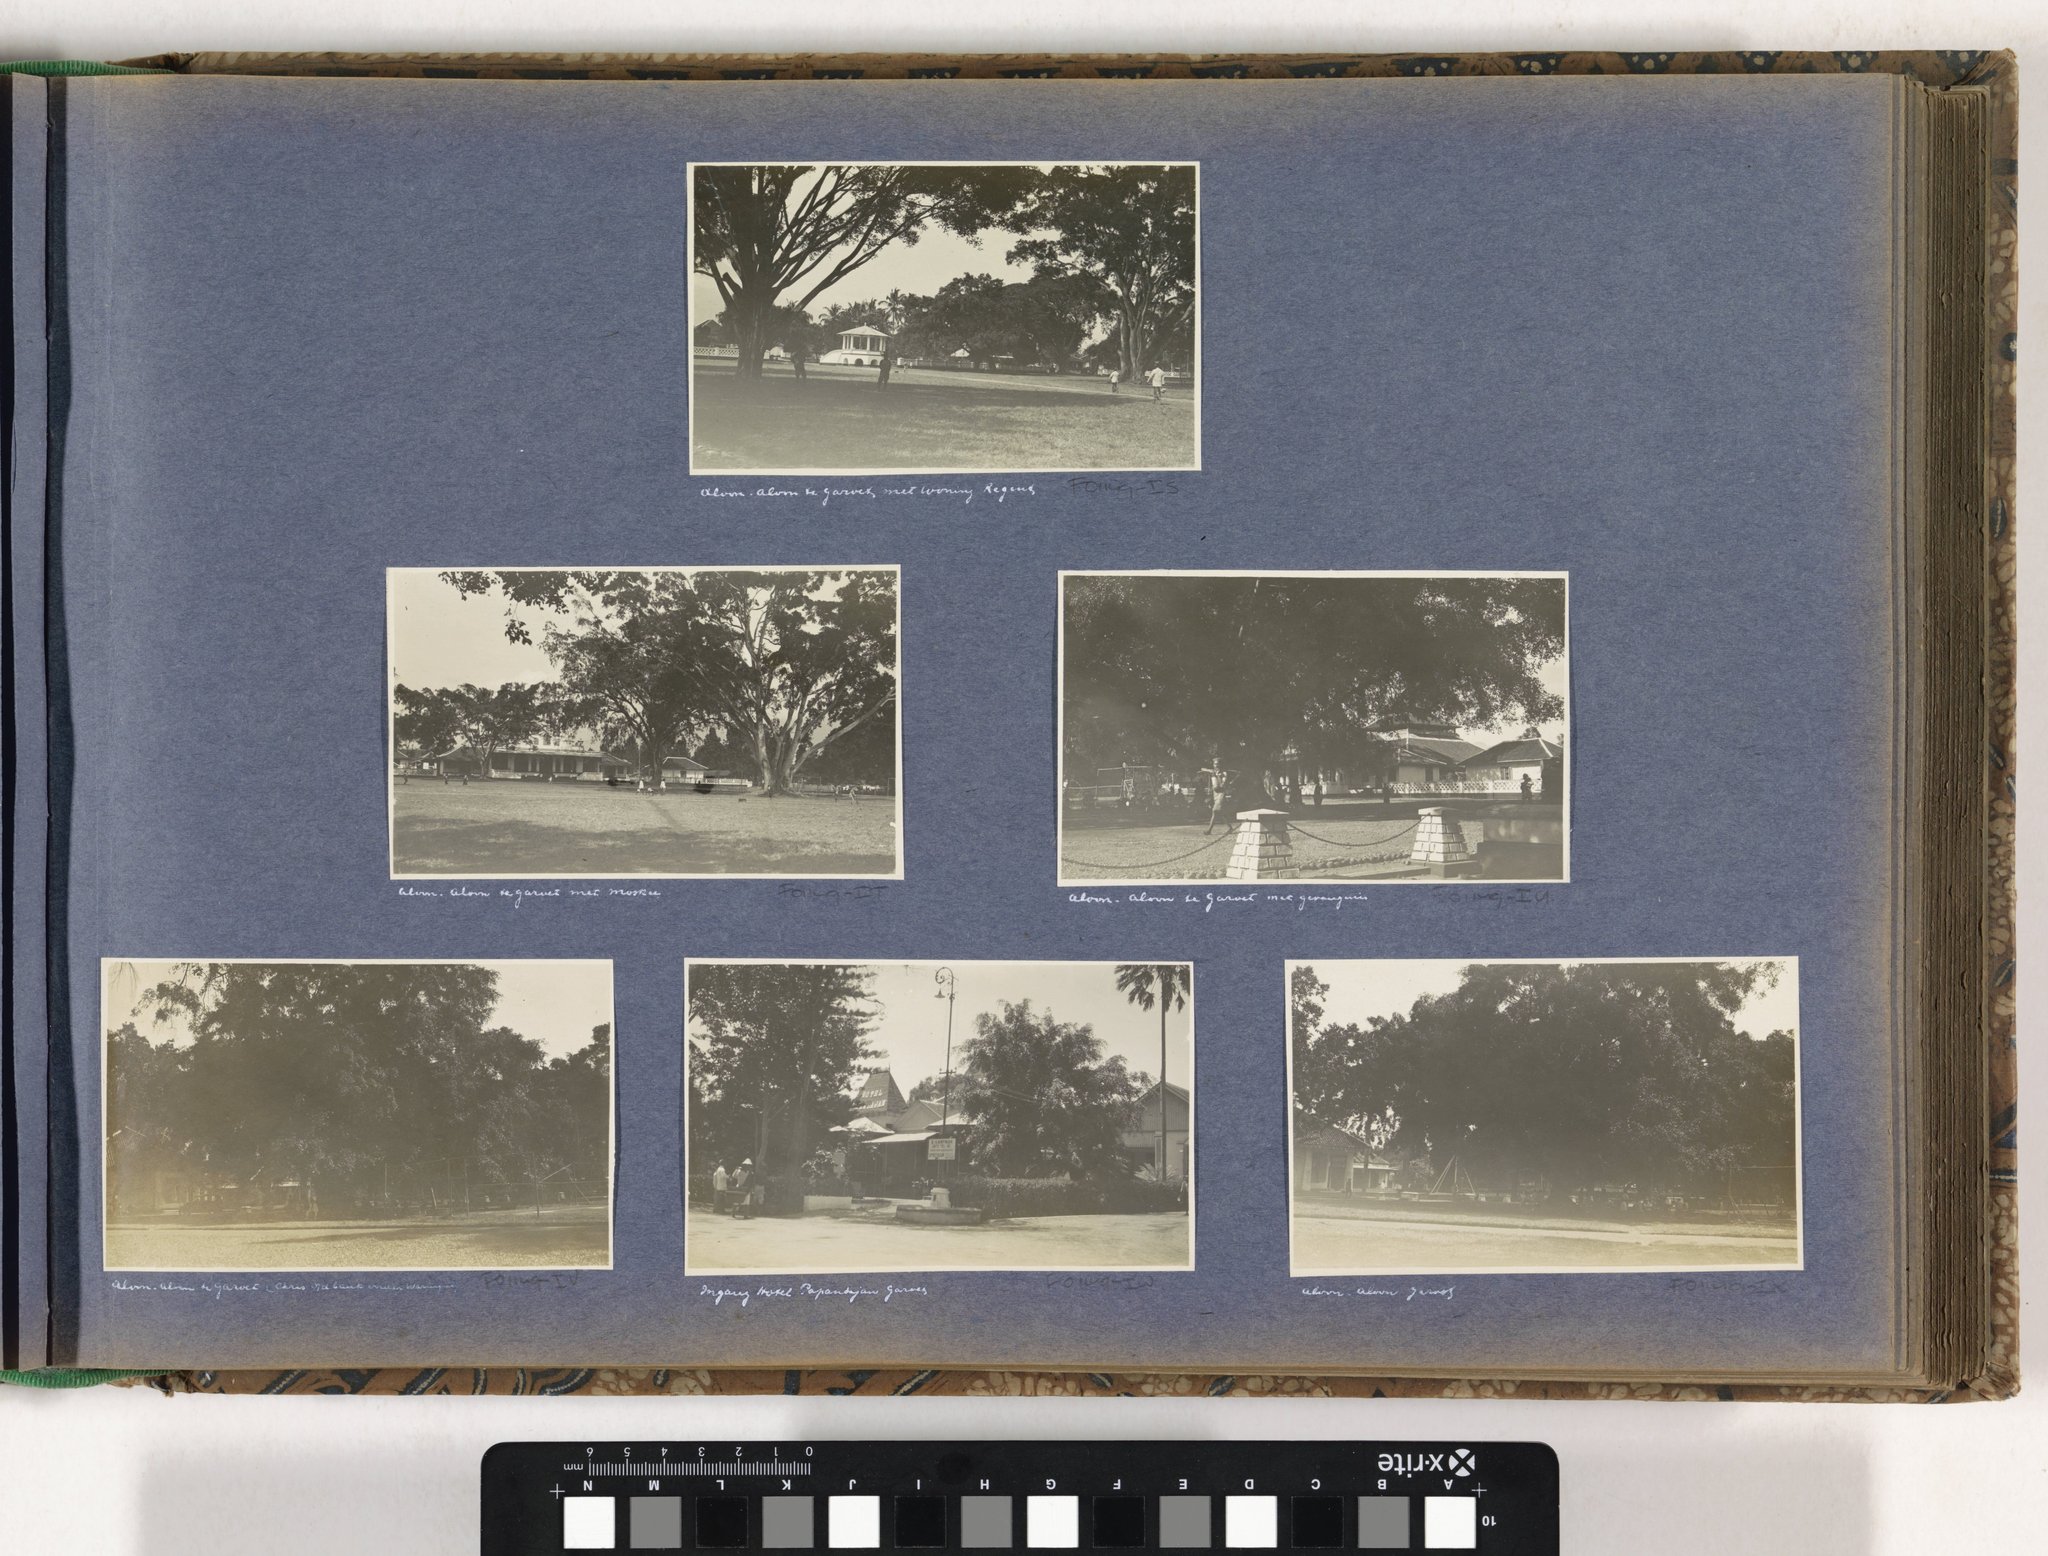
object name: photograph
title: Grasveld (alun-alun) met een moskee in Garut op Java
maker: Anonymous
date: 1900-1920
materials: paper, photographic support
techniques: gelatin silver print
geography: garut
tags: temple, shrine ~ islam, mohammedanism, lawn, square, place, circus, etc. (+ city(-scape) with figures, staffage), java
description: Onderdeel van reisalbum met foto's van bedrijvigheid en bezienswaardigheden op Sumatra en Java en van de reis naar en van Nederlands-Indië.